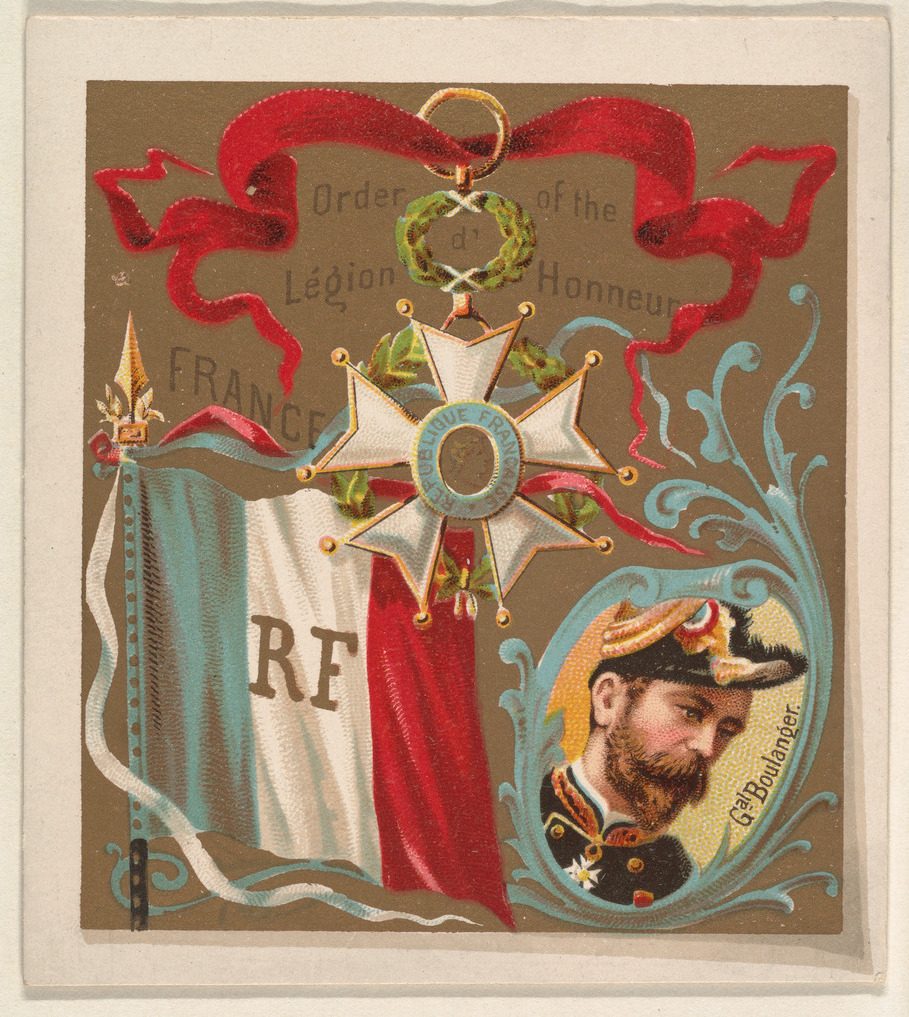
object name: print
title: France, from the International Cards series (N238), issued by Kinney Bros.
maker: kinney brothers tobacco company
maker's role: publisher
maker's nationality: american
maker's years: 1869-2011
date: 1888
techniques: color lithograph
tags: men,flags